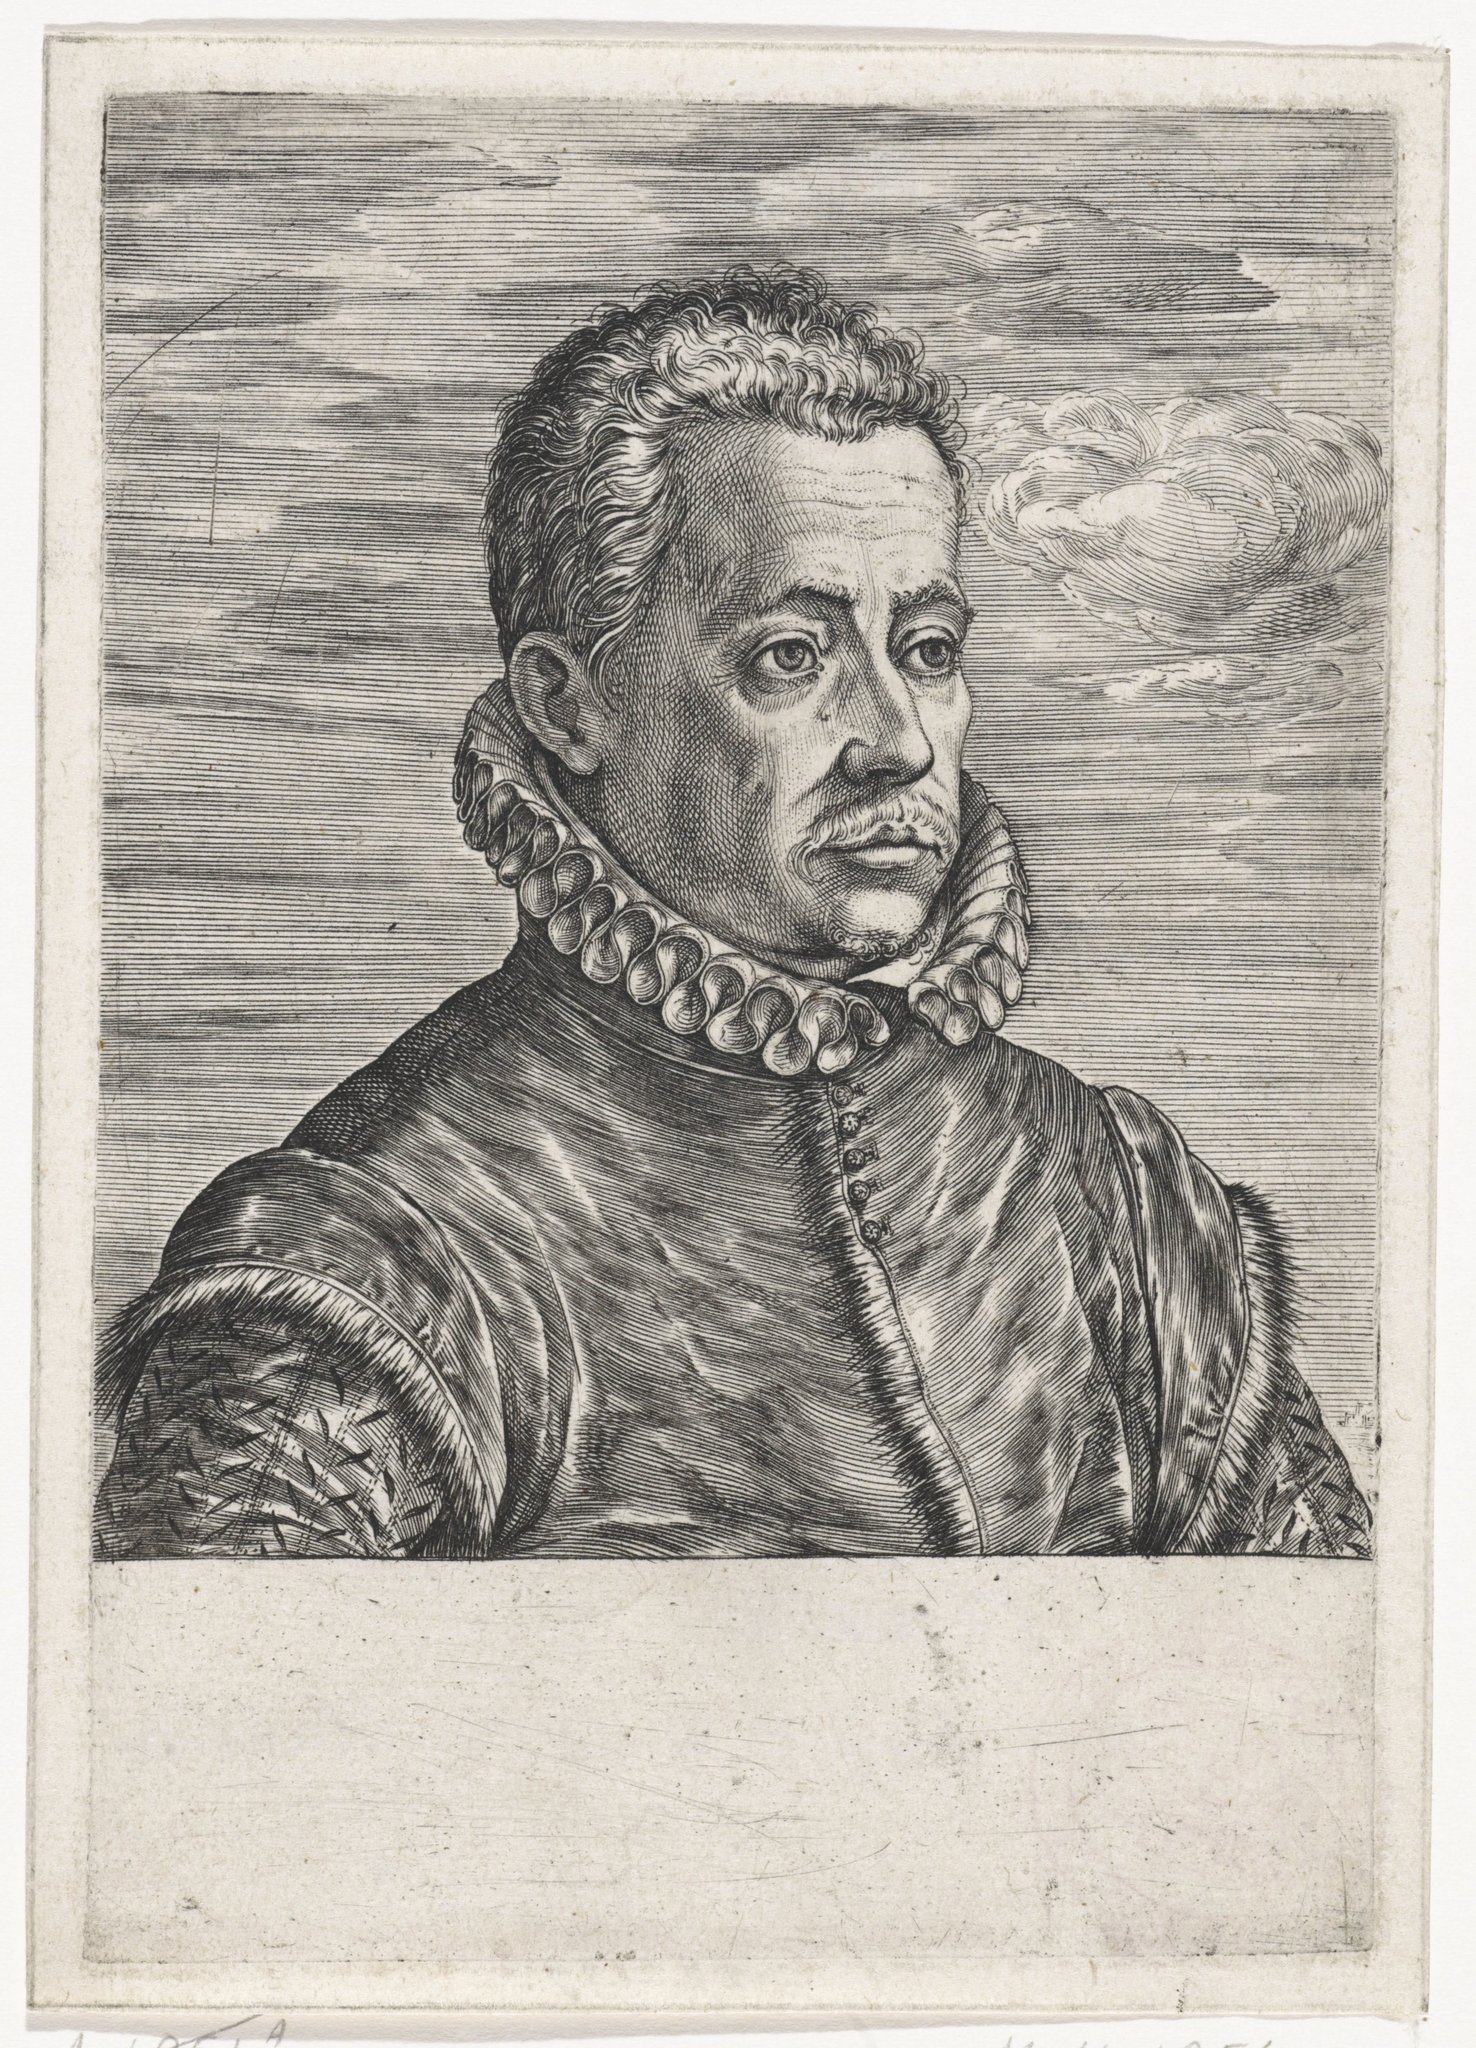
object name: print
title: Busteportret van een man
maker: johannes wierix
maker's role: draughtsman, print maker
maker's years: 1549-1618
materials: paper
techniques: engraving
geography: antwerp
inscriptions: number: ‘22. - 57.’, collector's mark: Lugt 240